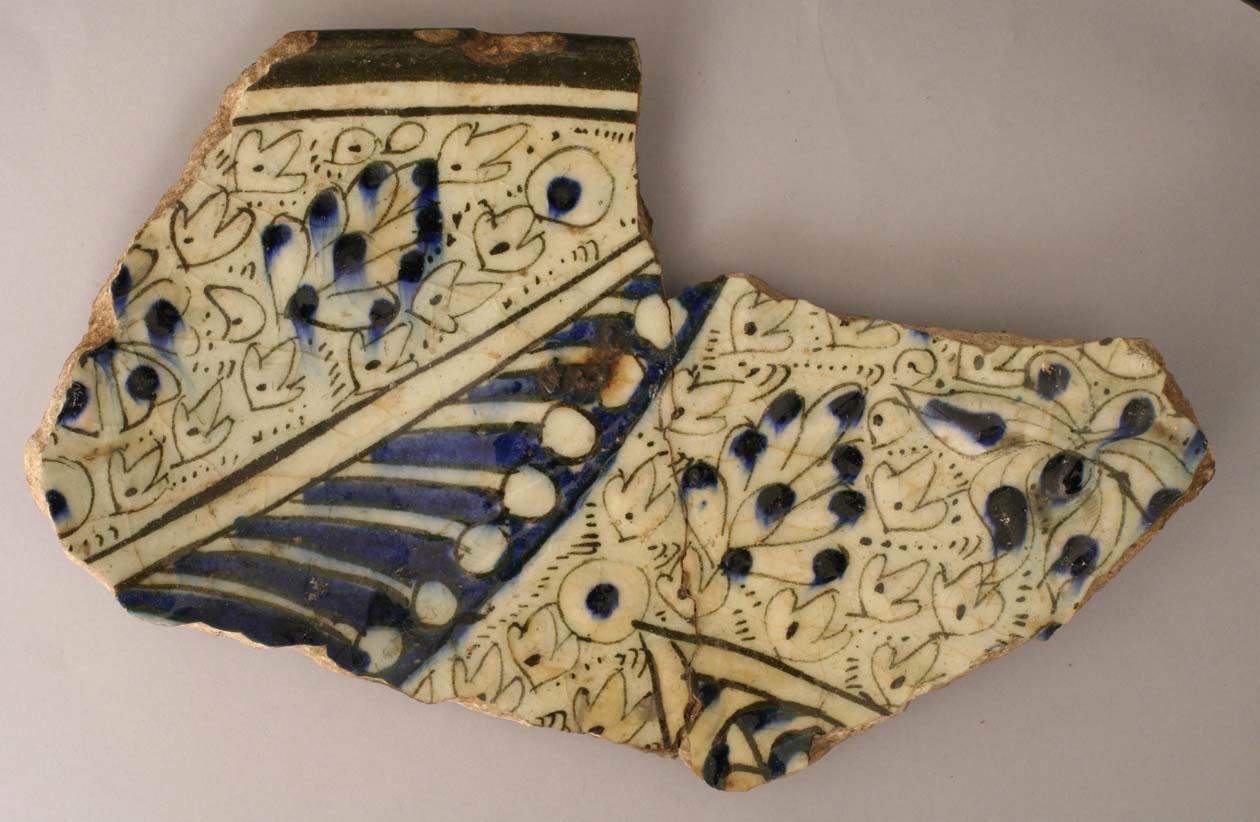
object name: fragment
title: Ceramic Fragment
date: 1301-1400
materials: stonepaste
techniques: painting, underglaze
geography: egypt